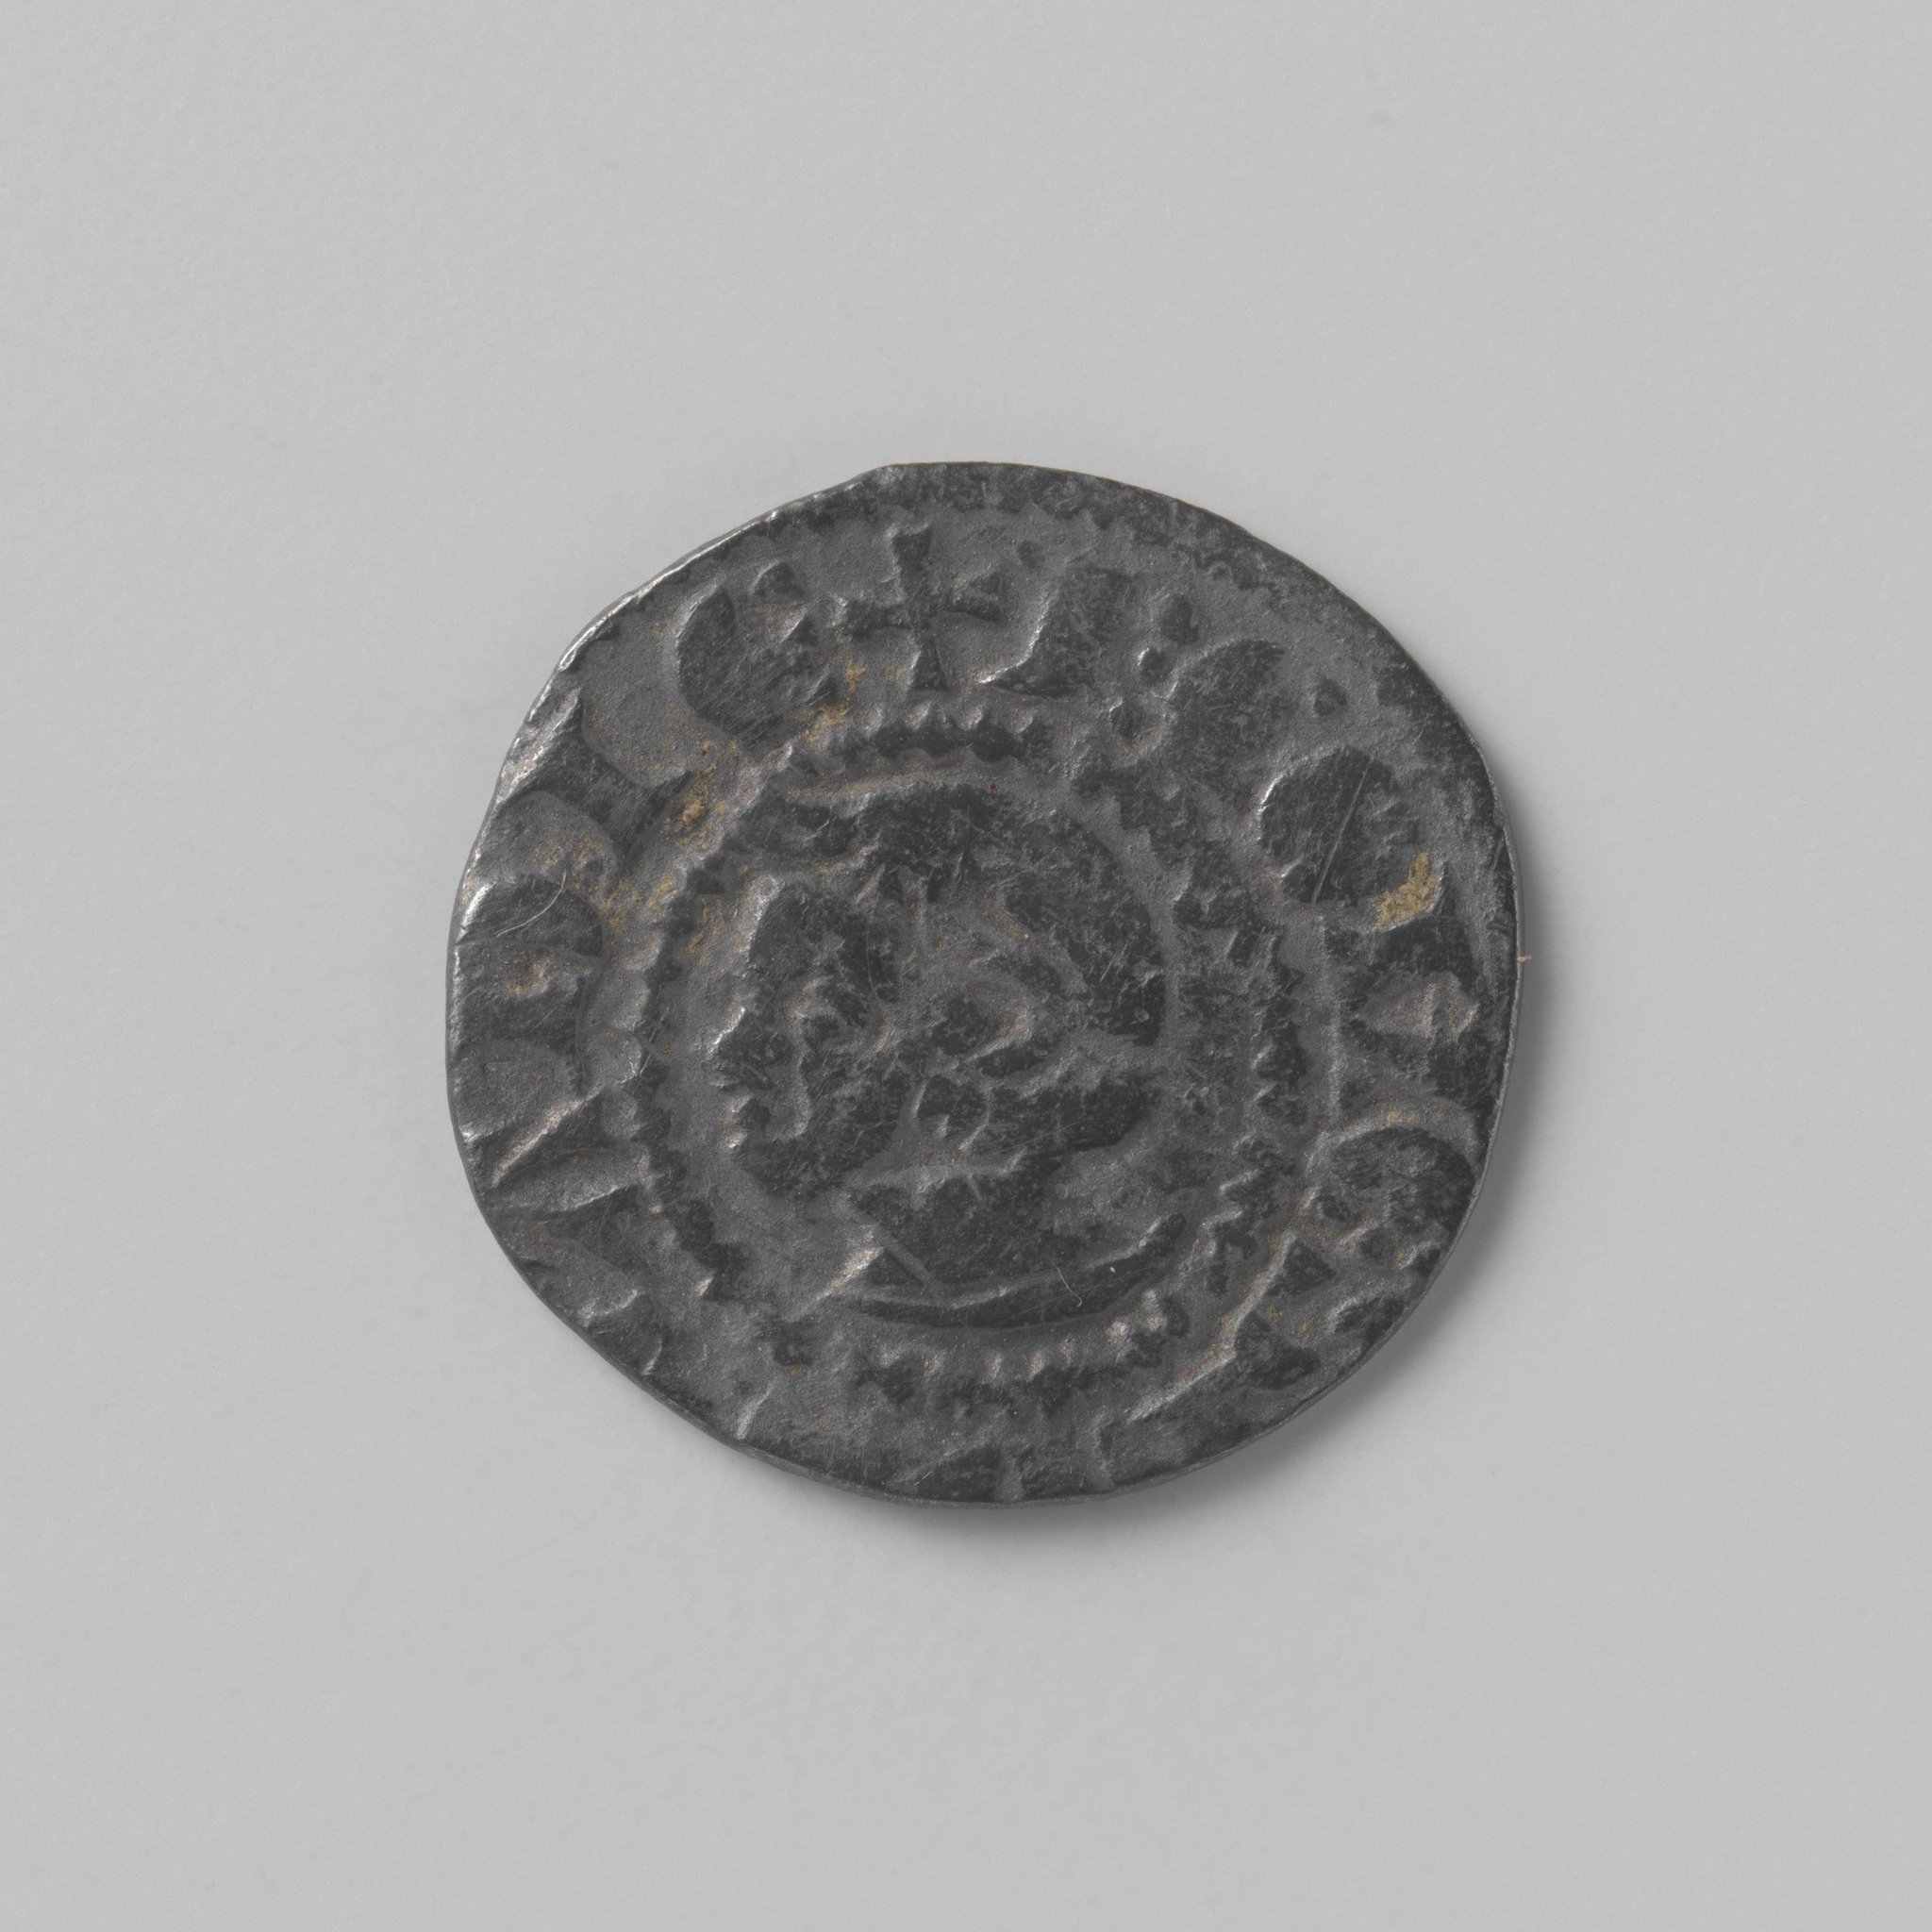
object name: penny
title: Hollandse penning van Jan I, 1296-1299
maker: jan i (graaf van holland)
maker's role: earl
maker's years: 1284-1299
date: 1298-1299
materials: silver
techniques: striking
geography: dordrecht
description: Zilveren munt. Voorzijde: hoofd naar links. Keerzijde: lang gevoet kruis.